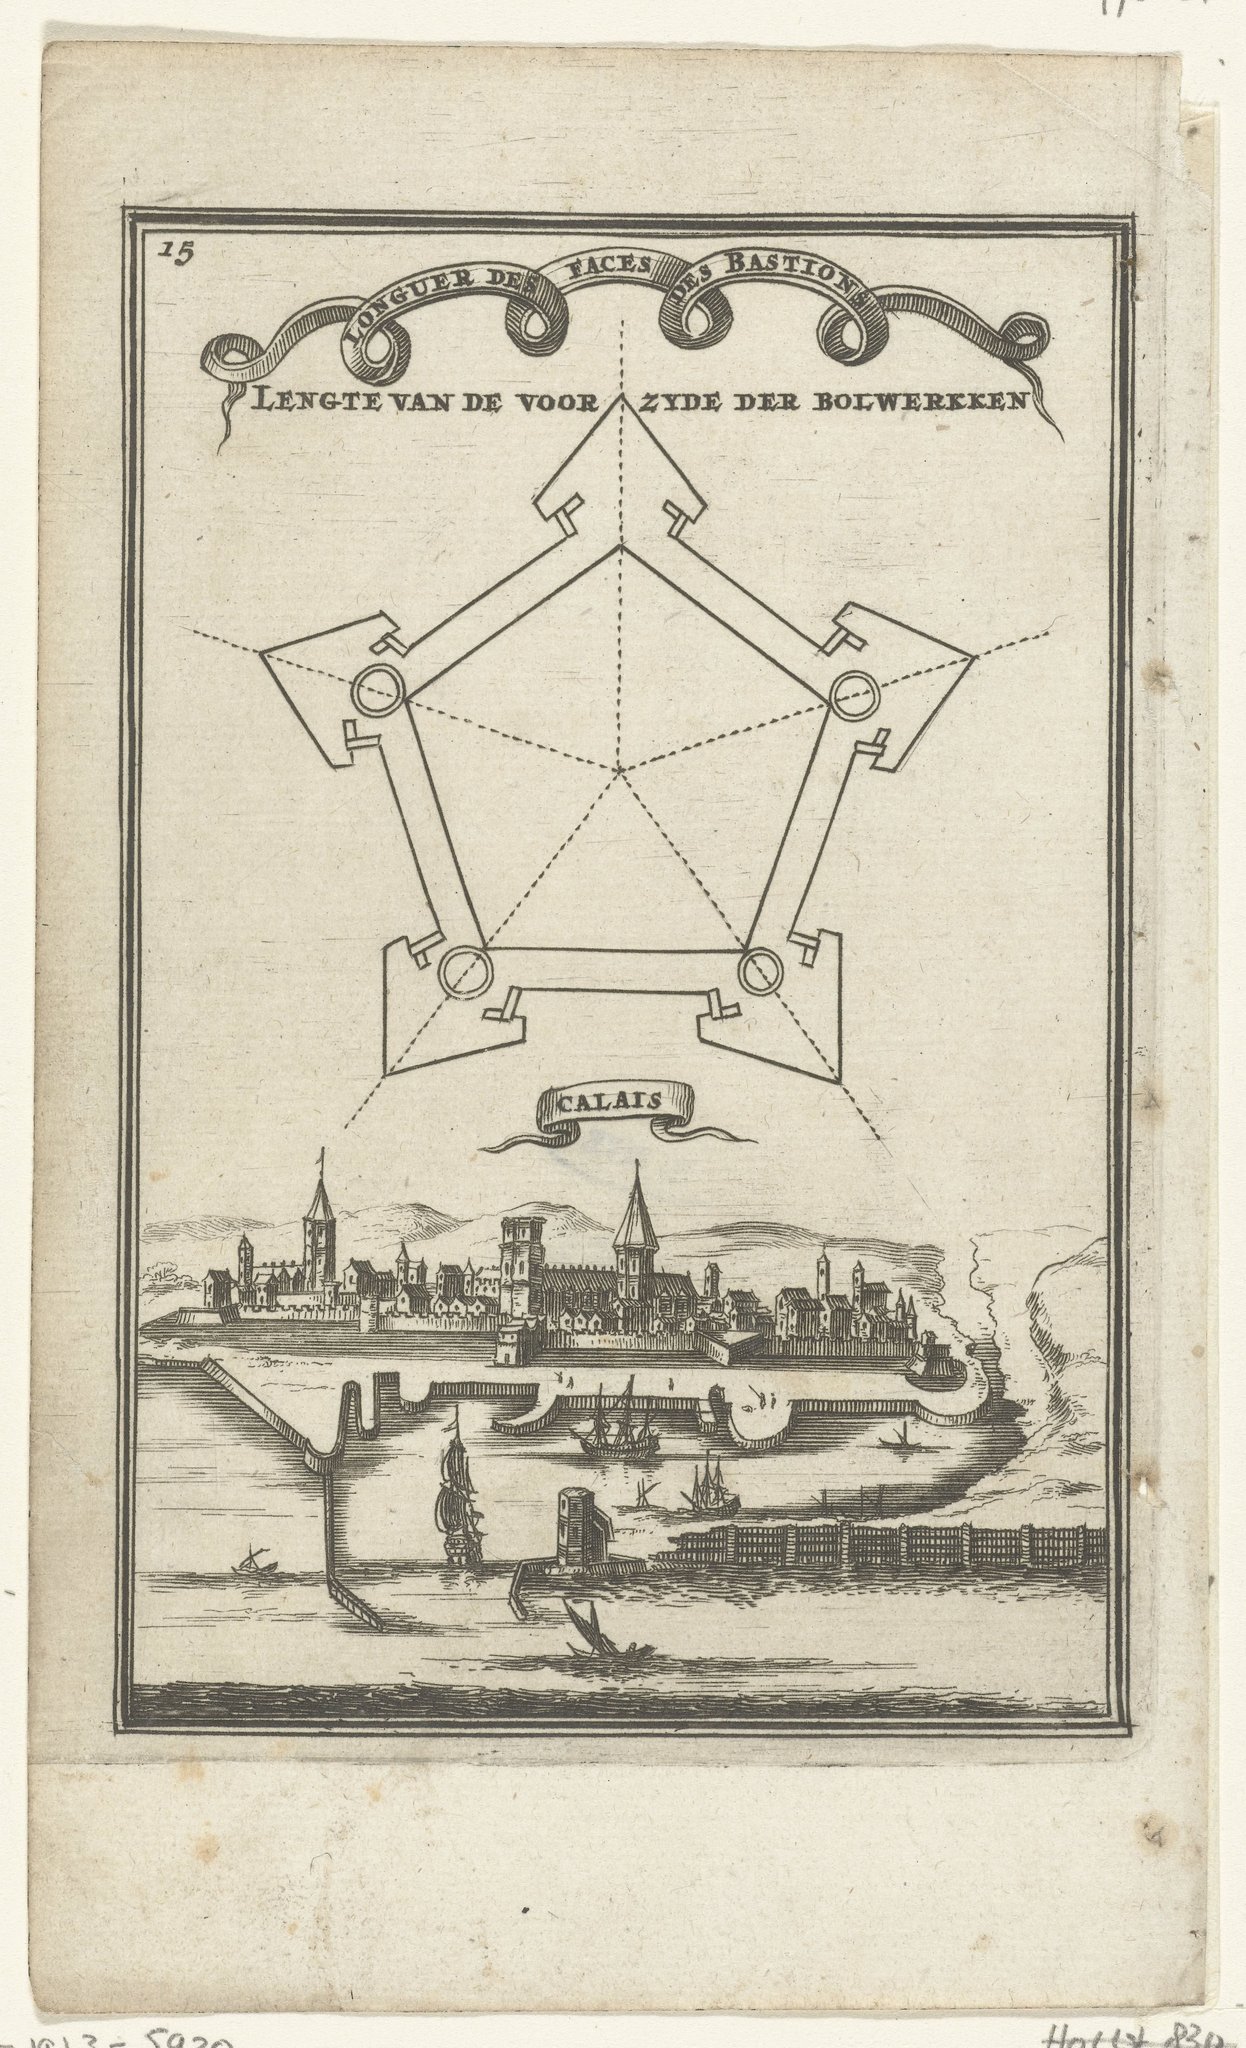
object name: print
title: Illustratie voor 'Den Arbeid van Mars' van Allain Manesson Mallet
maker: romeyn de hooghe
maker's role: draughtsman, goldsmith, painter, print maker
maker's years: 1645-1708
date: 1672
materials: paper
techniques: etching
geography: amsterdam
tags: harbour, fortifications, military engineering, prospect of city, town panorama, silhouette of city, mathematics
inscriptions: collector's mark: Lugt 2228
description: Grondplan voor een vesting, fort of versterking (vijfhoek). Daaronder een gezicht op Calais. In de hoek linksboven het cijfer 15 (= het nummer van de pagina in het boek waartegenover de illustratie geplaatst is).